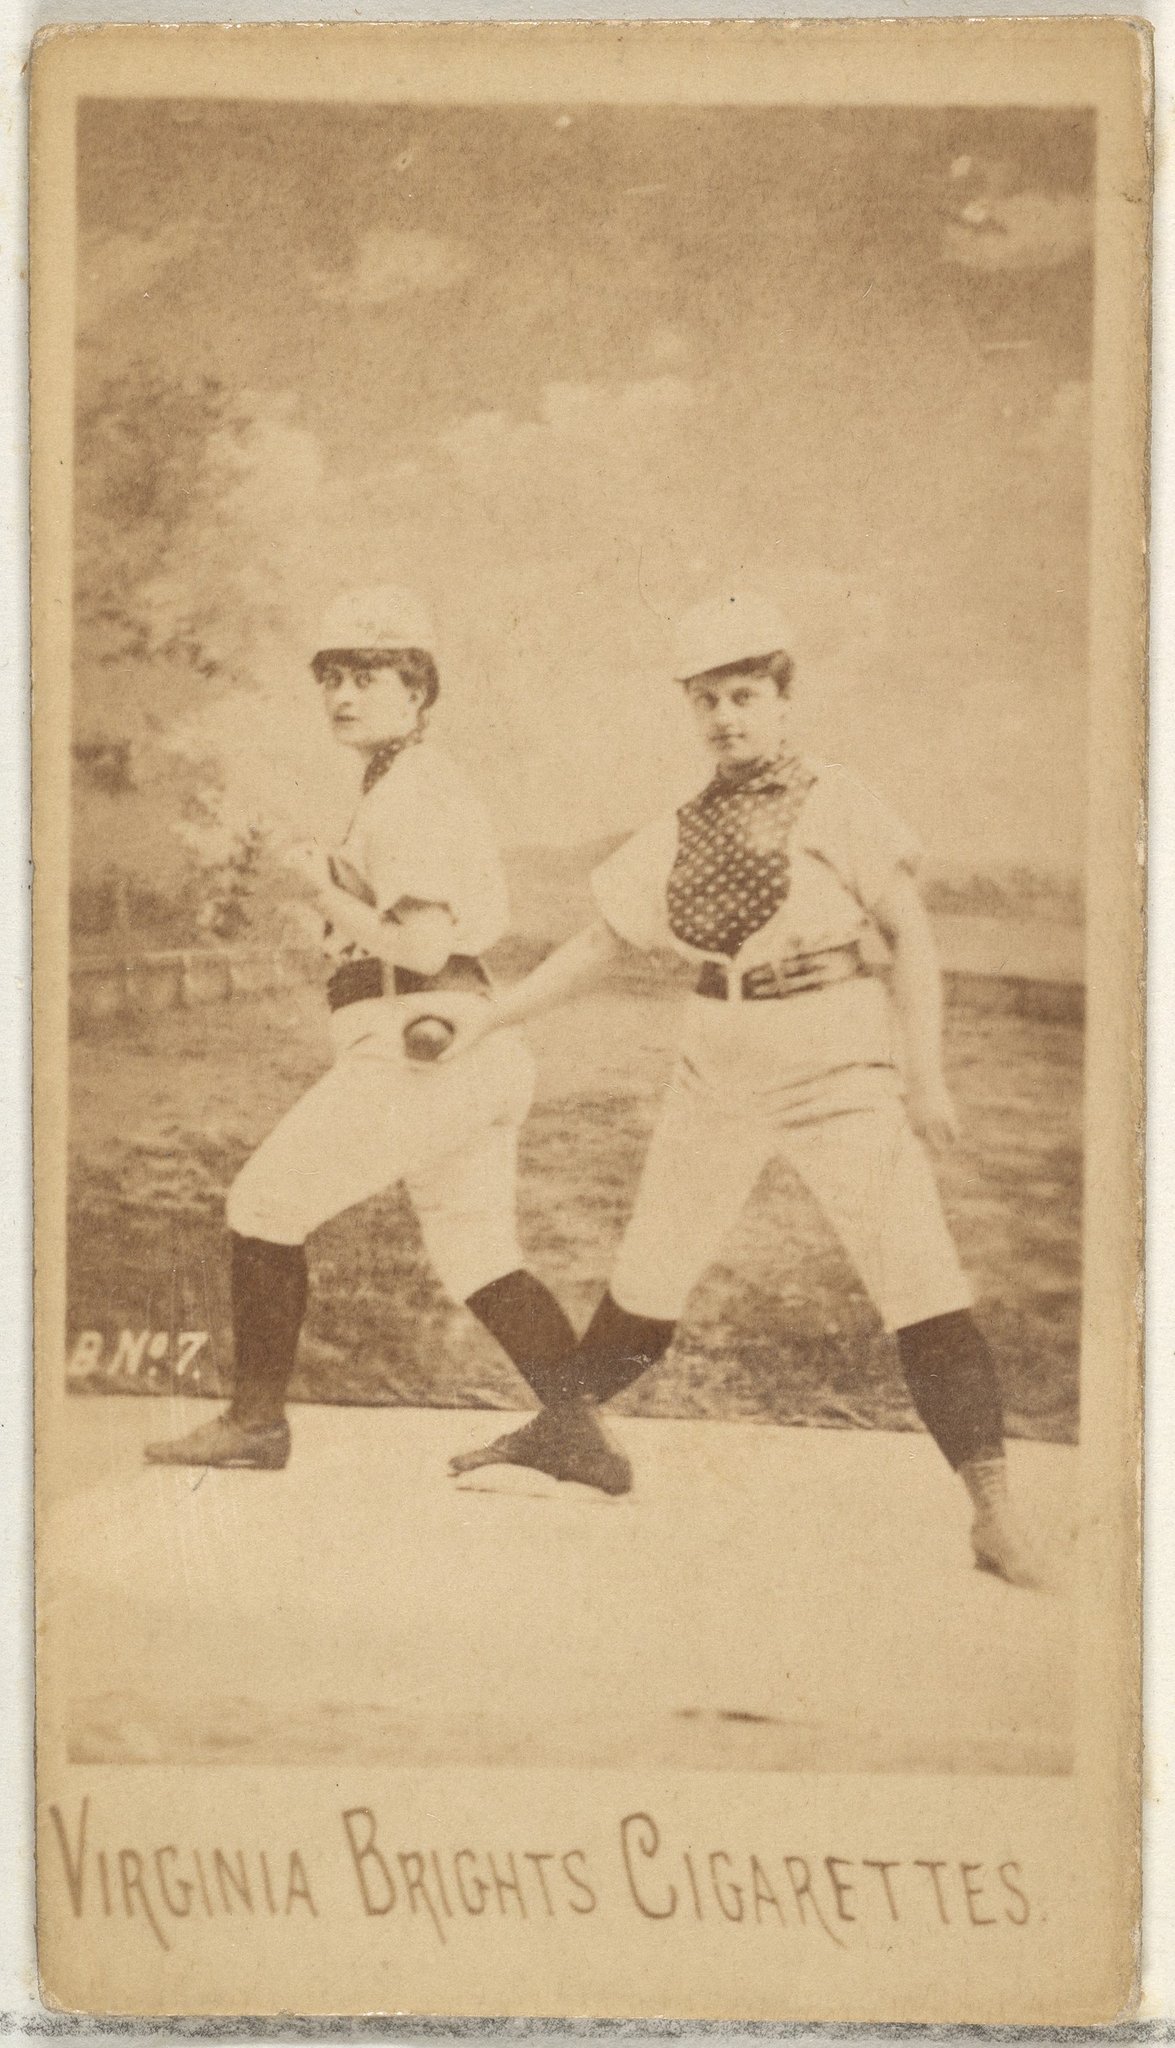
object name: baseball card, photograph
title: Card 7, from the Girl Baseball Players series (N48, Type 1) for Virginia Brights Cigarettes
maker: allen & ginter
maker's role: publisher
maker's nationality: american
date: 1886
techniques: albumen silver print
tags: portraits,women,baseball,athletes